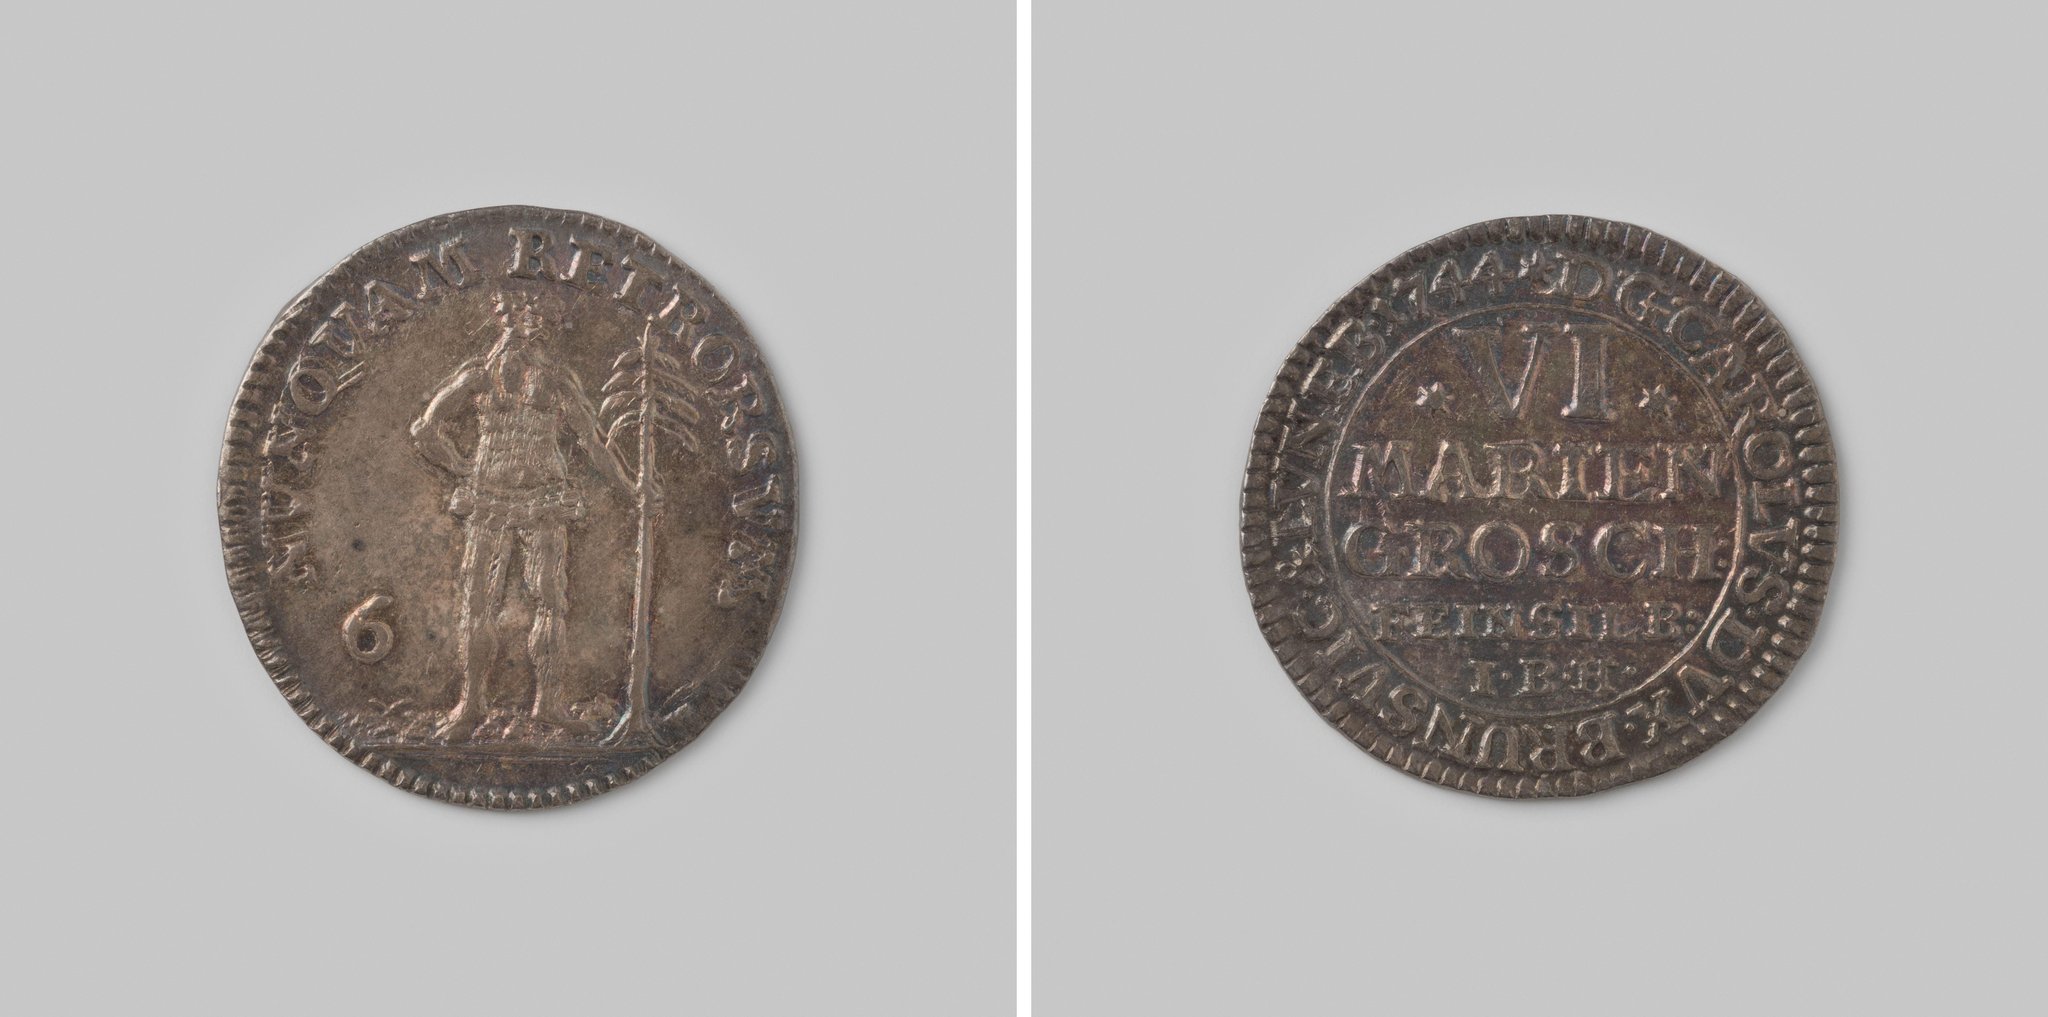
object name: z mariëngroschen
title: Brunswijk-Wolfenbuttel, Karl I, 6 mariëngroschen,1744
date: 1744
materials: silver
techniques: striking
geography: clausthal-zellerfeld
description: Zilveren munt. Voorzijde: in landschap staande wildeman, met linkerhand denneboom vasthoudend. Cijfer 6 in het veld. Keerzijde: waarde-aanduiding in vier regels. Jaartal in omschrift. Gladde rand.